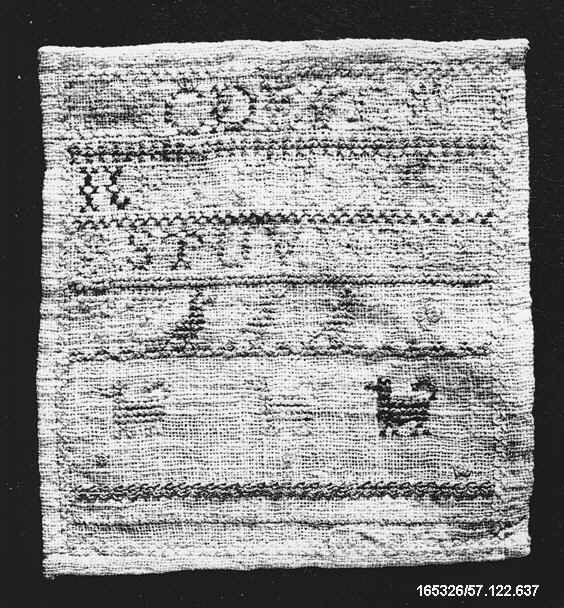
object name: sampler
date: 1801-1900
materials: cotton, silk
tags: dogs